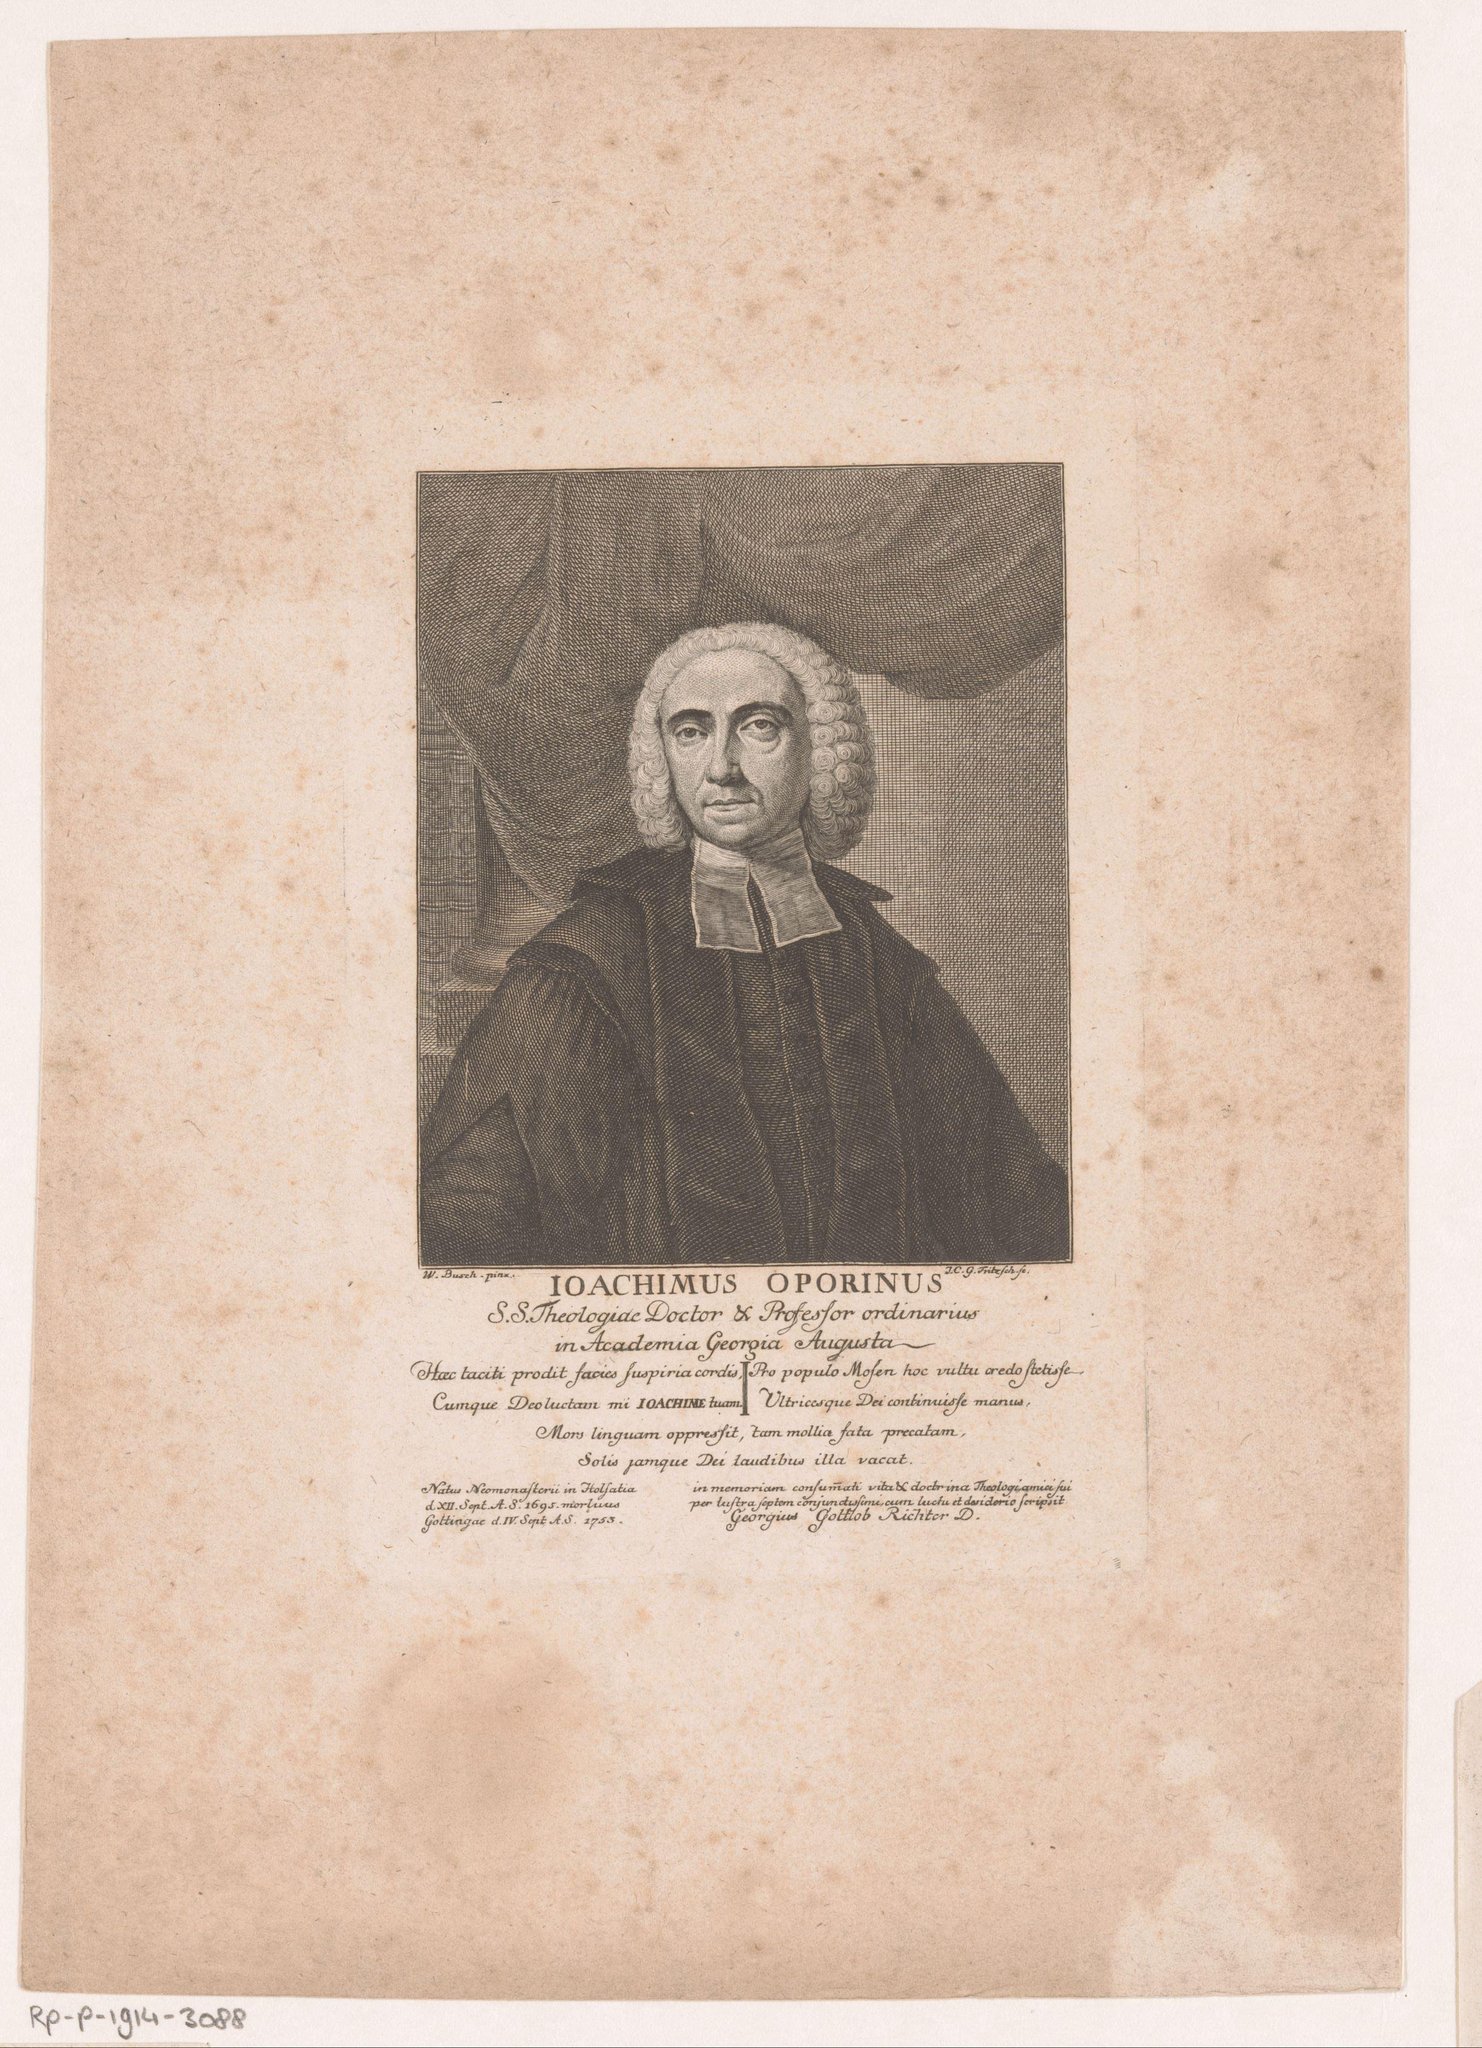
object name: print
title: Portret van Joachim Oporin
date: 1753-1803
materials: paper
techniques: engraving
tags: bookshelves, theologian, historical persons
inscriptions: collector's mark: Lugt 2228